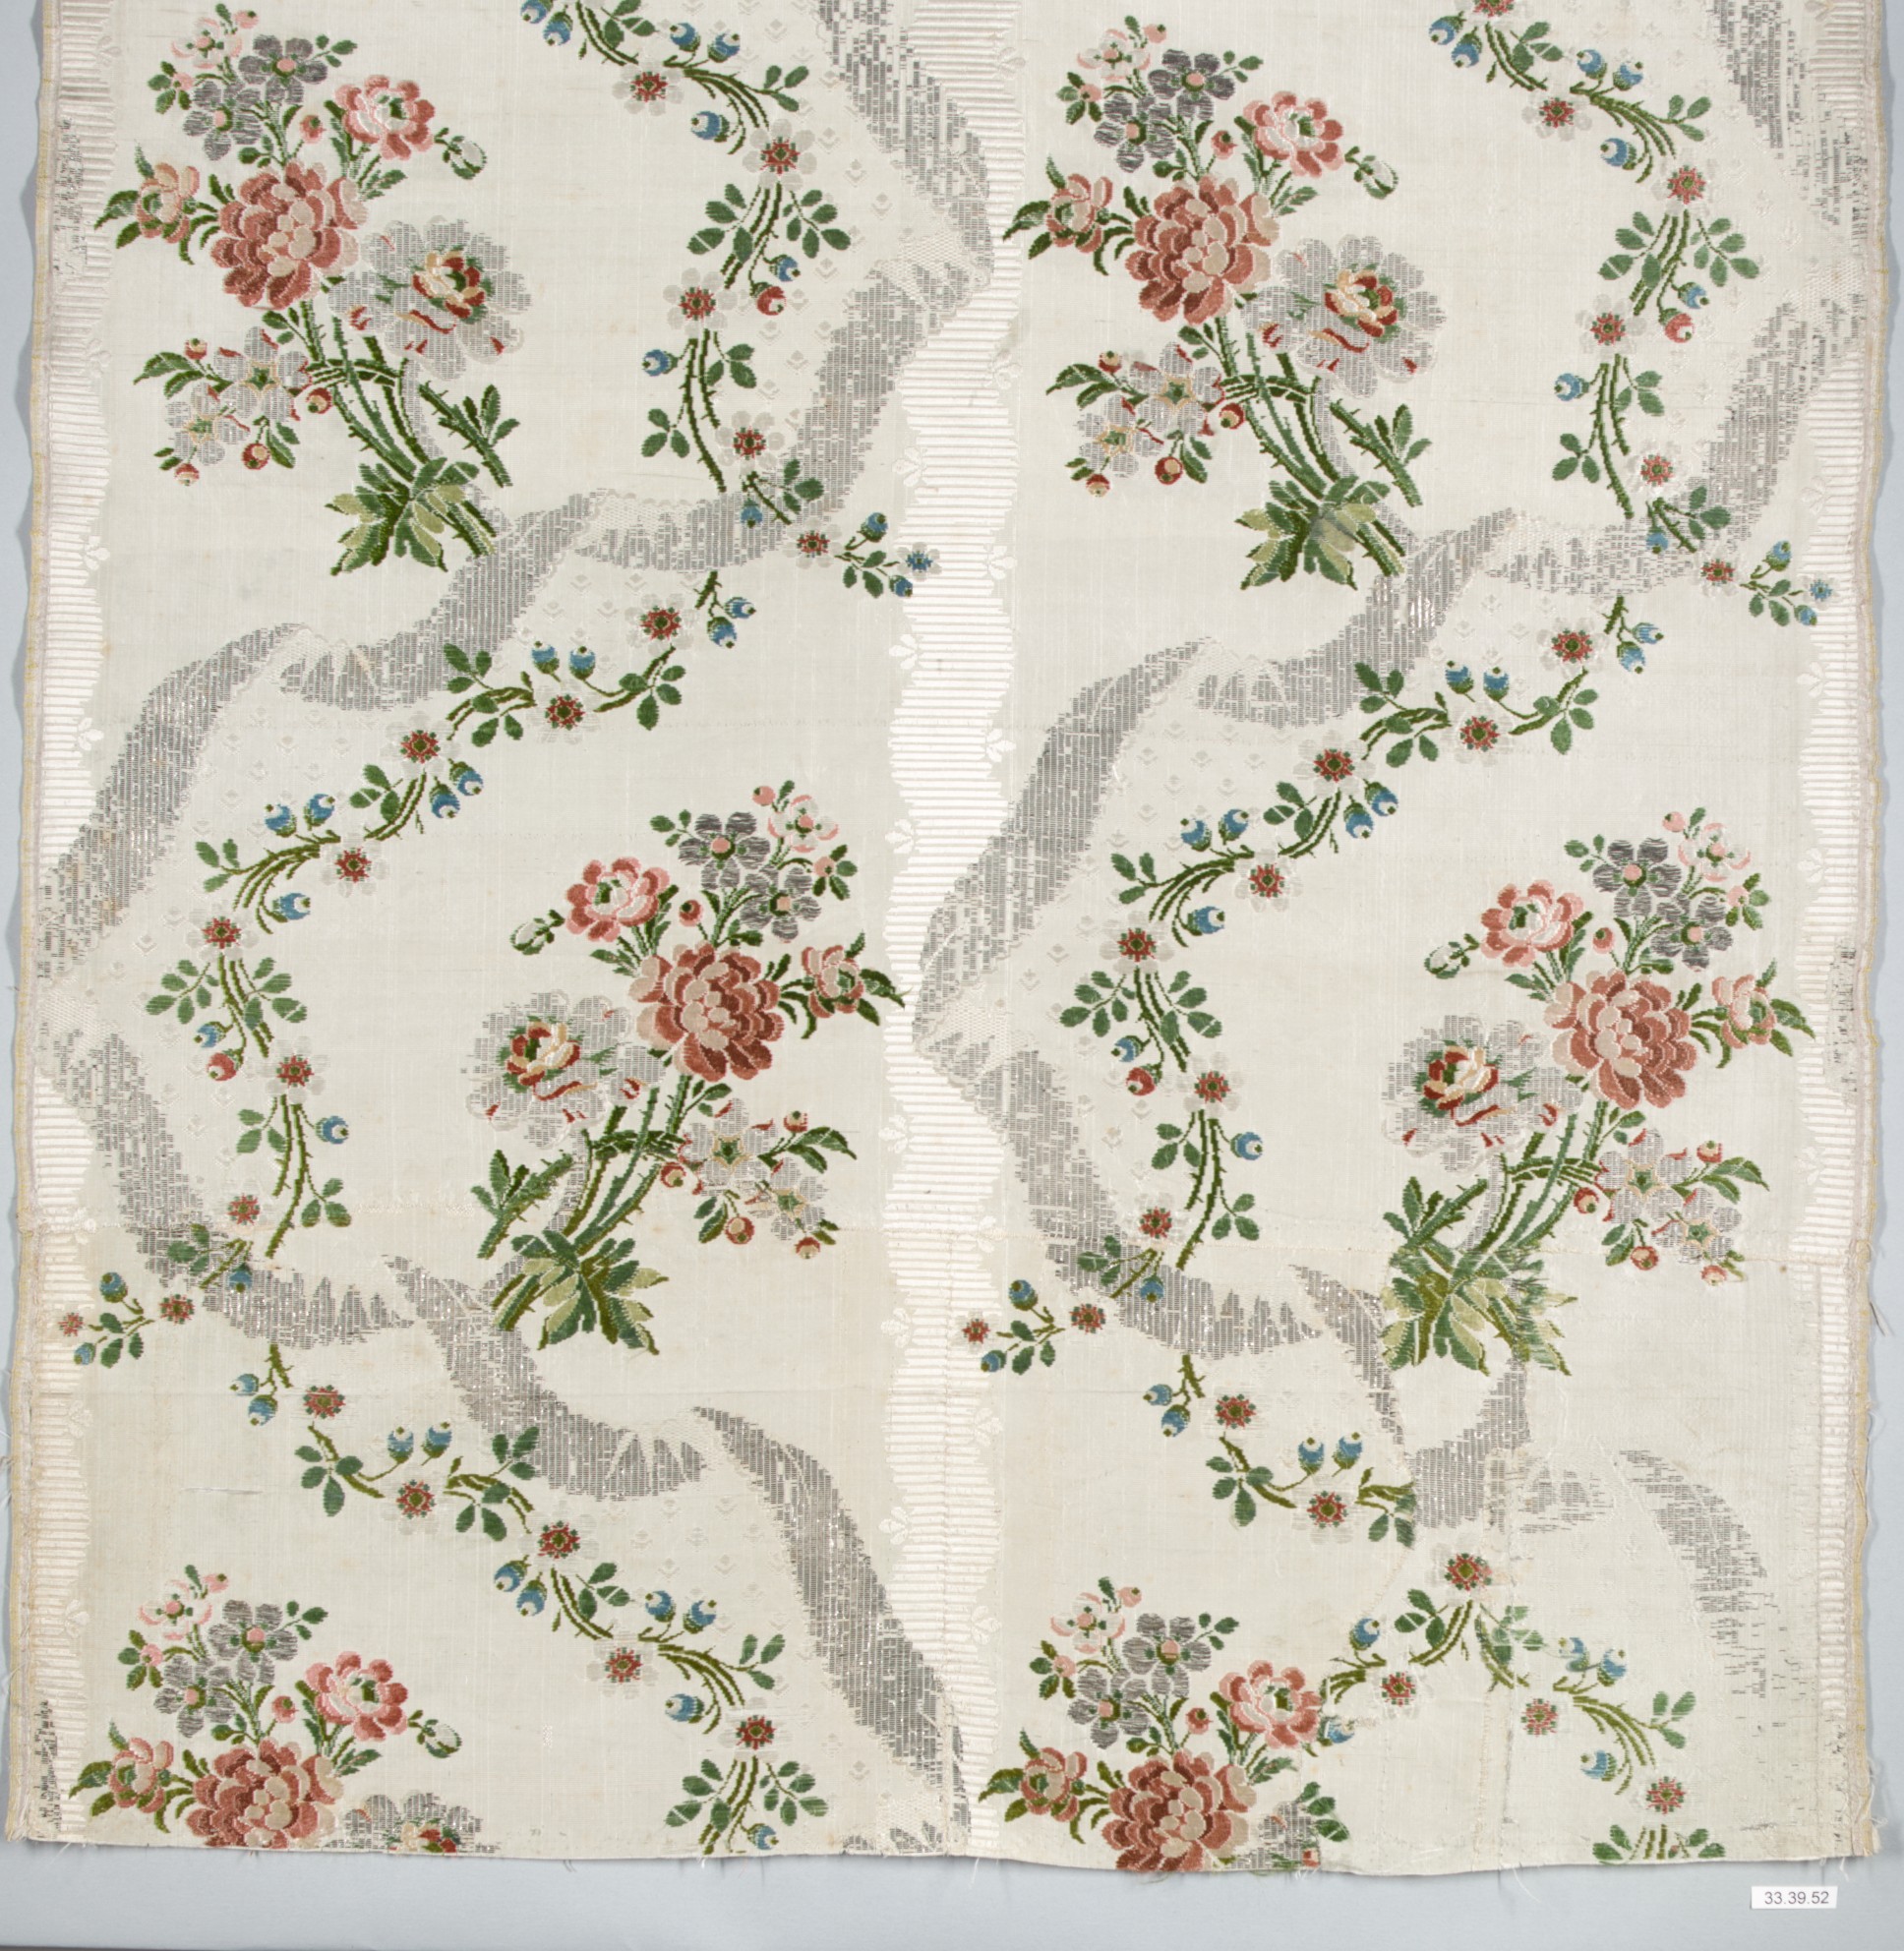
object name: piece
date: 1760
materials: metal thread, silk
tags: flowers,leaves